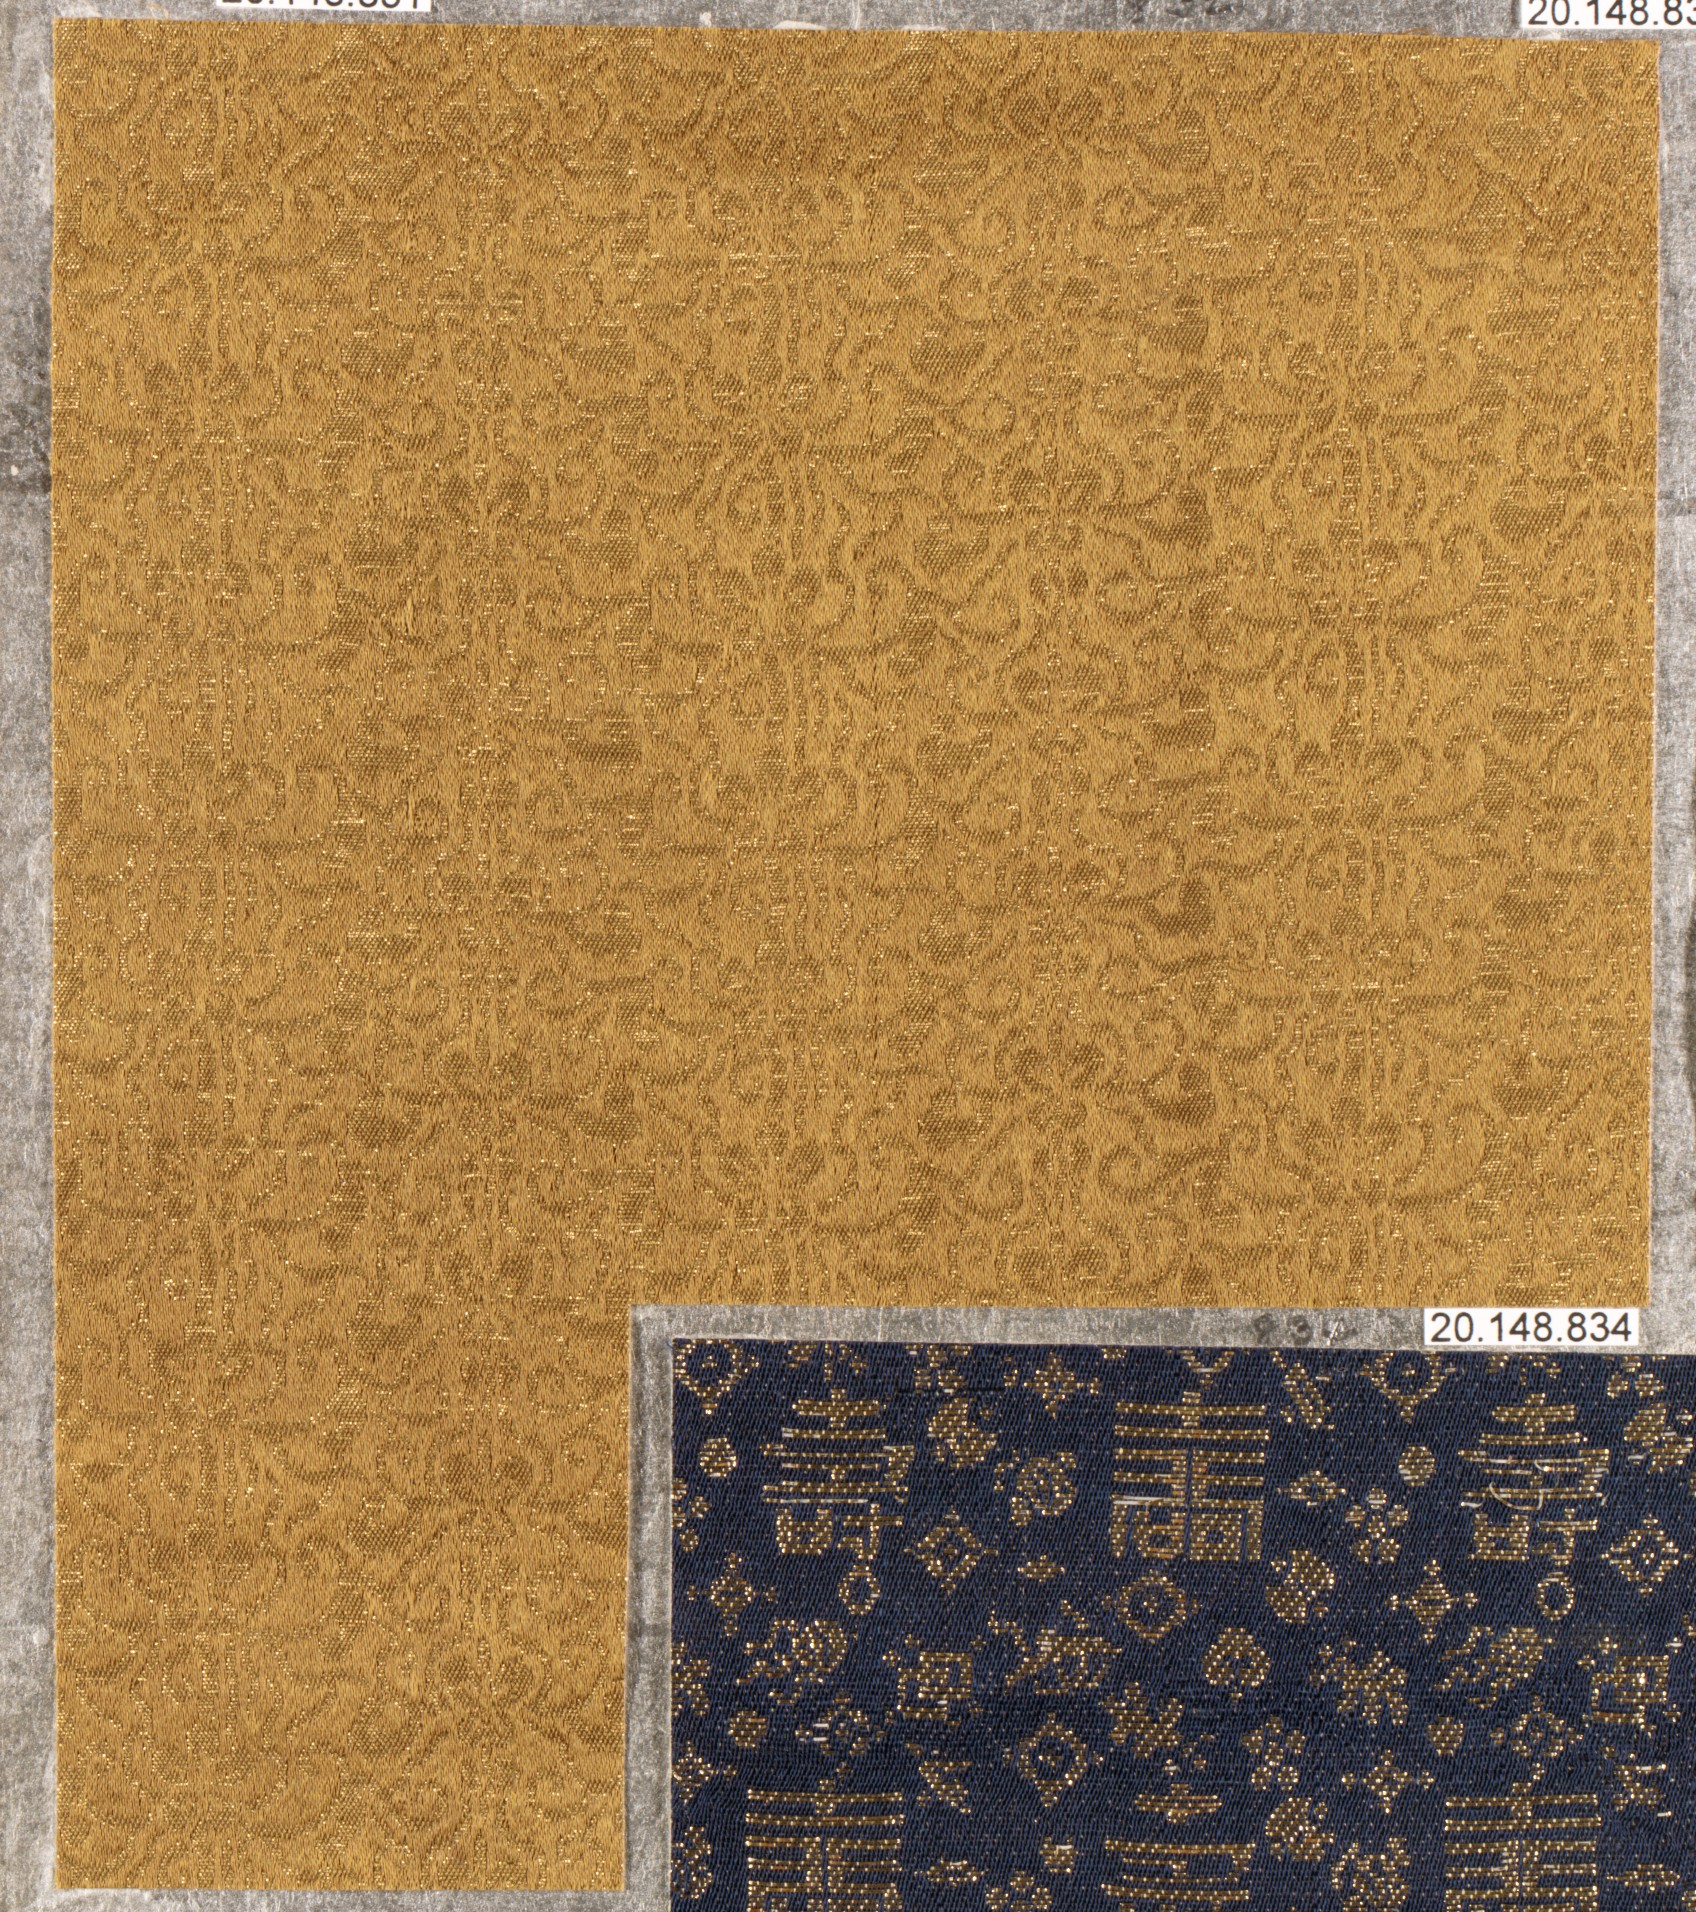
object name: piece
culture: japanese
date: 1701-1800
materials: silk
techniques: compound weave